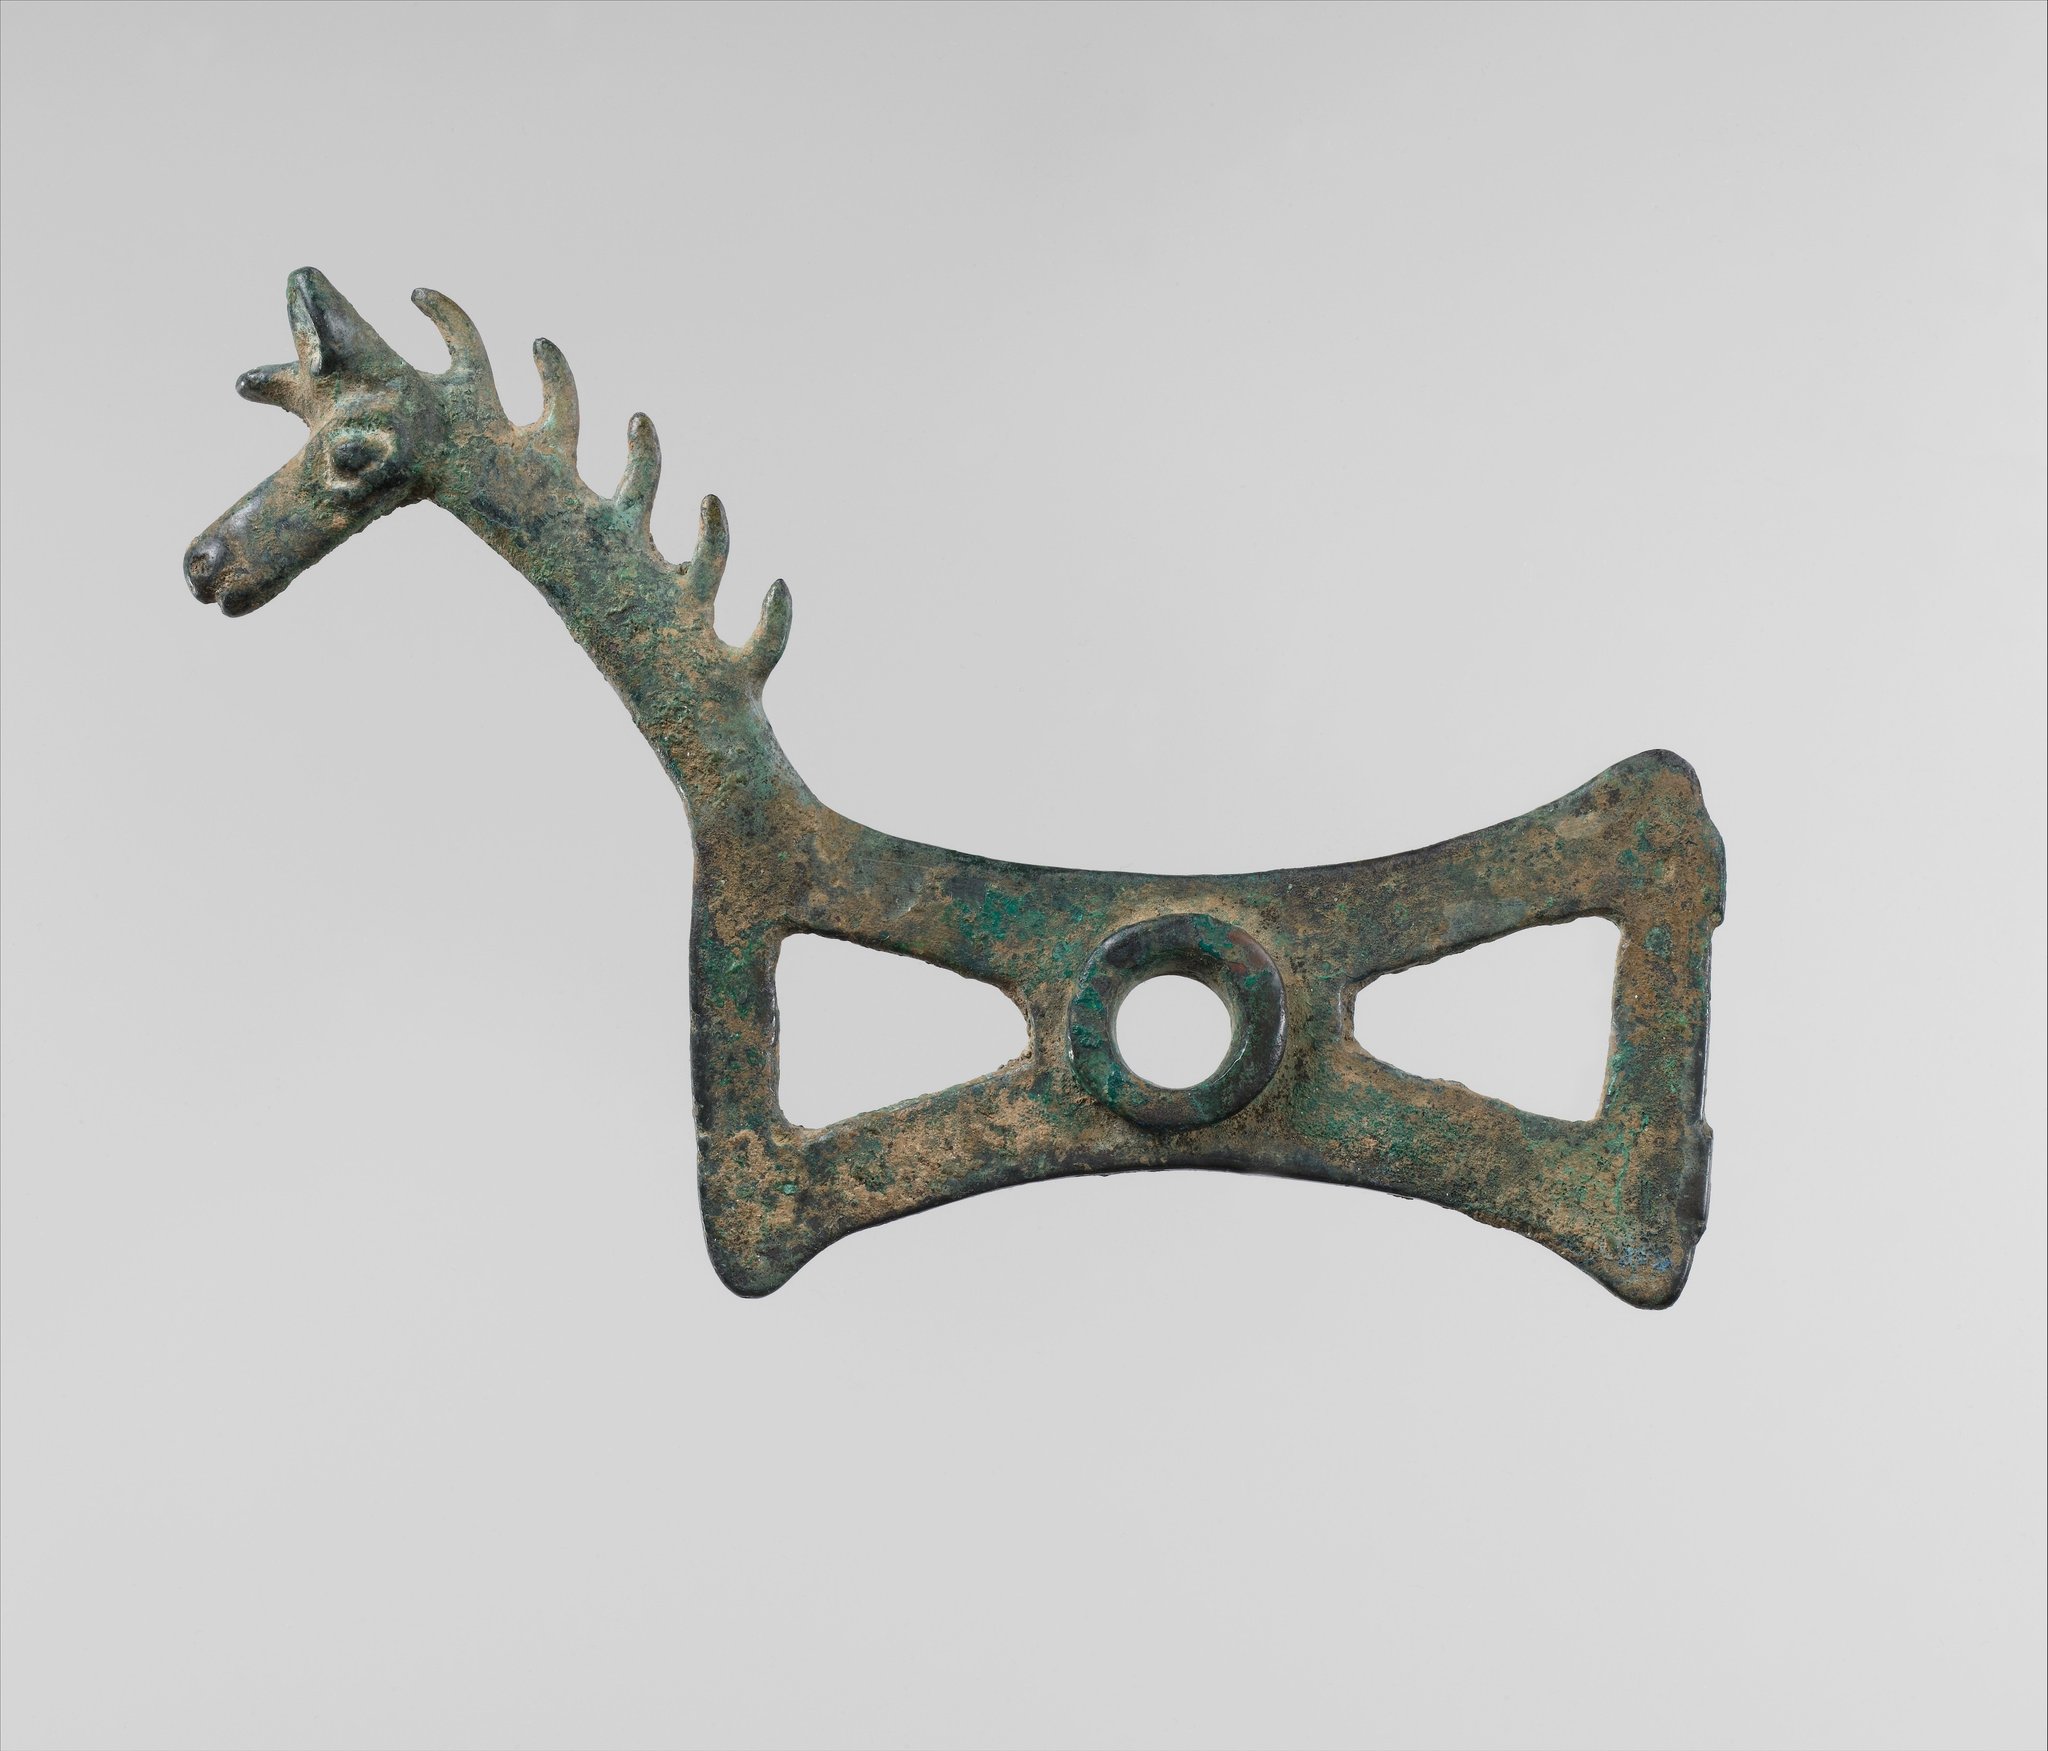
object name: horse bit cheekpiece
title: Horse bit cheekpiece in form of a horse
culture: iranian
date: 800-601 BCE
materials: bronze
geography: iran, probably from luristan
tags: horses